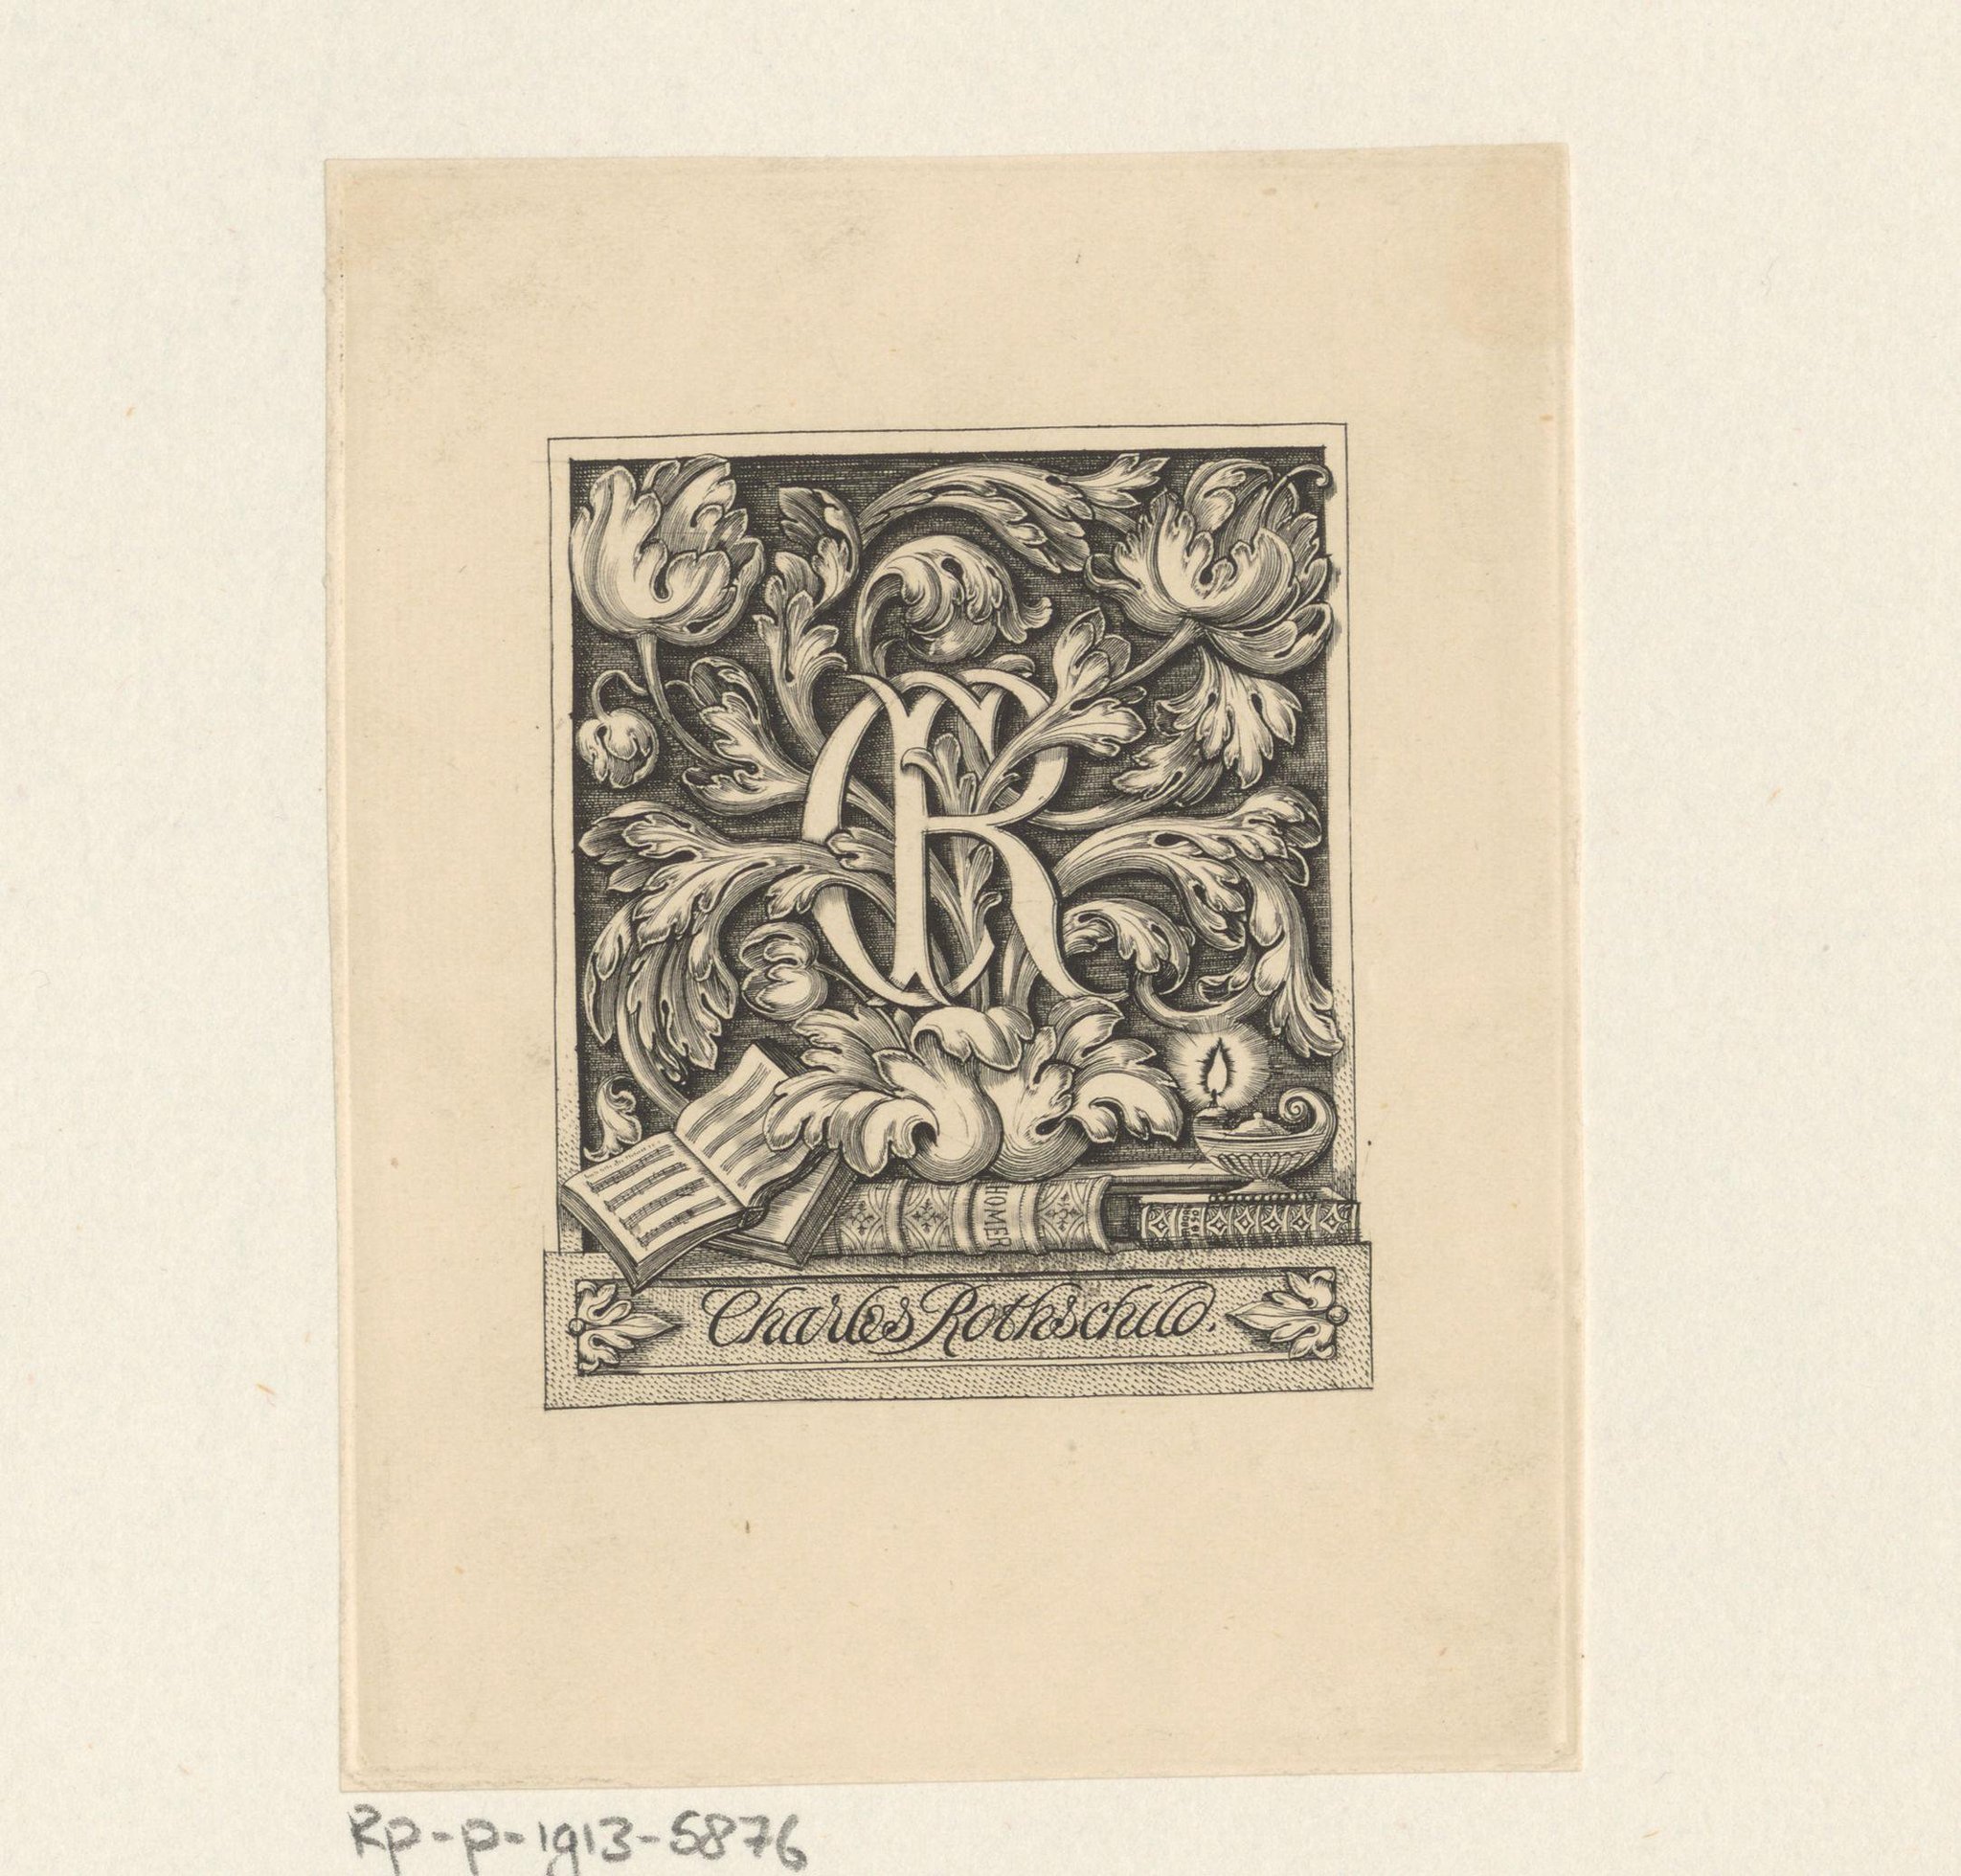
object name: bookplate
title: Ex libris van Charles Rothschild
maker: charles william sherborn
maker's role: print maker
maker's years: 1831-1912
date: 1890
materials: paper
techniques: engraving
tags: plants and herbs: acanthus, book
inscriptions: collector's mark: Lugt 2760, collector's mark: Lugt 2233